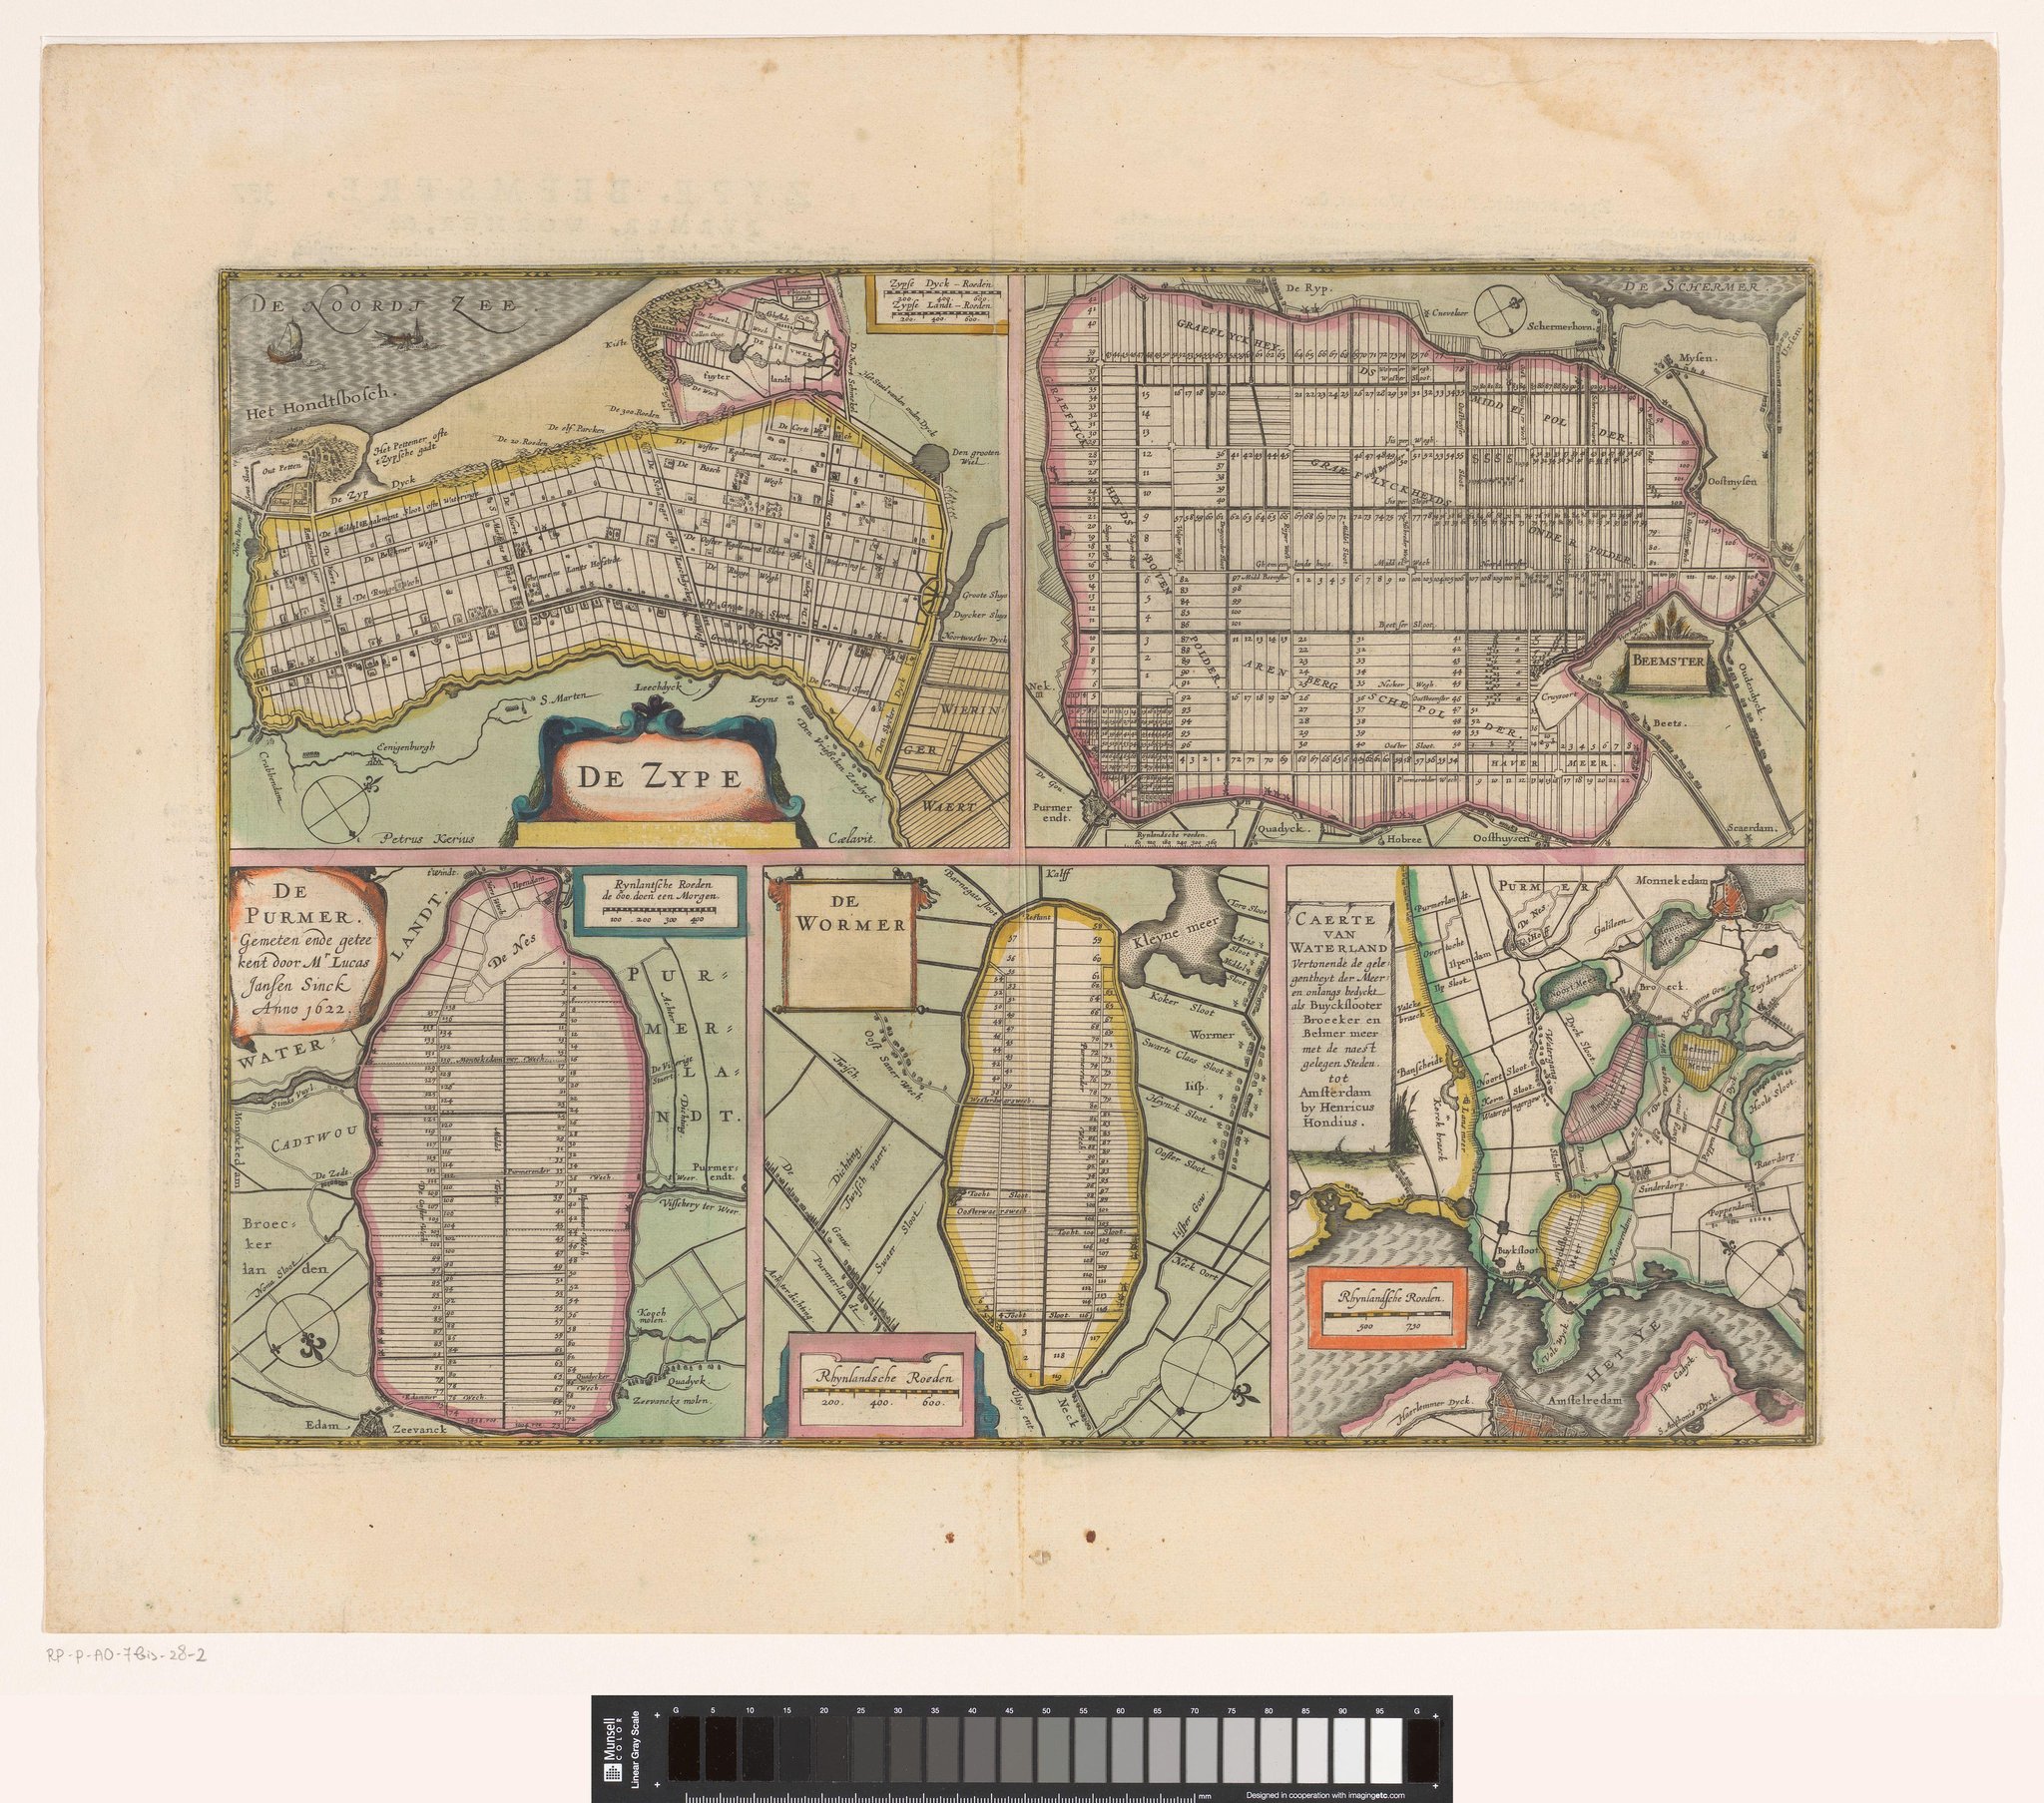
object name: print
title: Blad met kaarten van de polders van de Zijpe, Beemster, Purmer, Wormer en een kaart van Waterland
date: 1631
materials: paper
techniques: engraving, etching, hand coloring, letterpress printing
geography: amsterdam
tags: maps of separate countries or regions, polder, reclaimed land, beemster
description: Blad met vijf kaarten van bedijkte en verkavelde polders. Linksboven de Zijpe (1597) met daarop rechts de Wieringerwaard en rechtsboven twee schaalstokken: Zypse dyck-roeden; Zypse landt-roeden. Rechtsboven de Beemster (1612) met daarop linksonder een schaalstok: Rynlandsche roeden. Linksonder de Purmer (1622) met daarop rechtsboven een schaalstok: Rynlantsche roeden de 600 doen een morgen. Onder in het midden de Wormer (1626) met daarop linksonder een schaalstok: Rhynlandsche roeden. Rechtsonder een kaart van Waterland met daarop de polders van het Buikslotermeer, Broekermeer en Belmermeer (1628) en linksonder een schaalstok: Rhynlandsche roeden. Op verso Franse tekst.